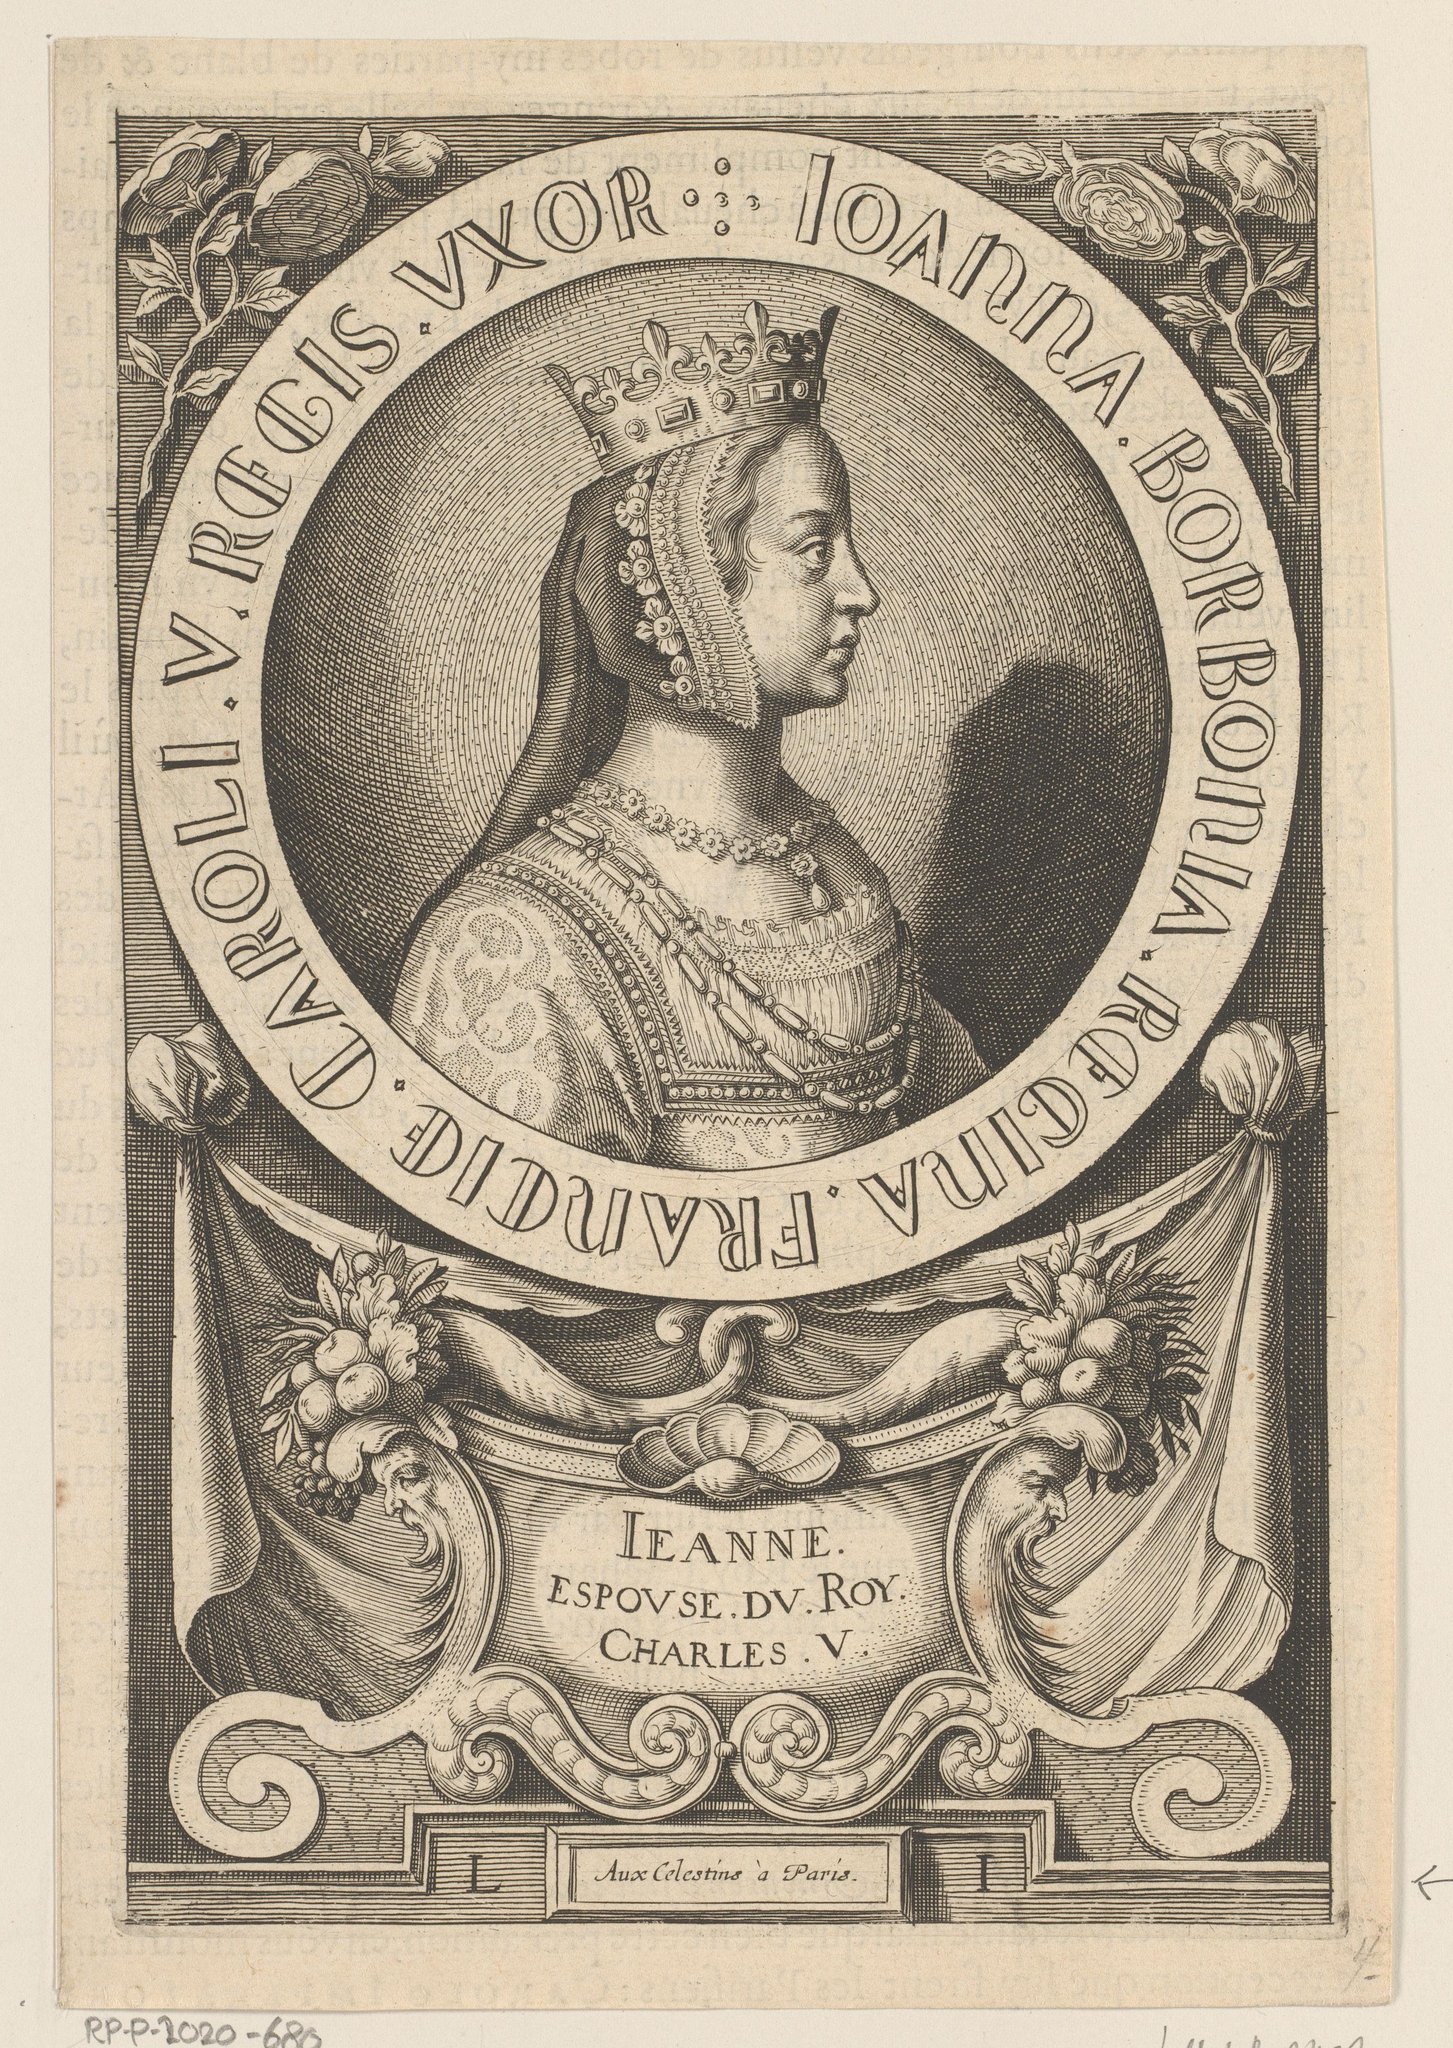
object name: book illustration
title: Portret van Johanna van Bourbon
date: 1643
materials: paper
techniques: engraving, letterpress printing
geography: paris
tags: paris, historical persons, queen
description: Prent uit: Eudes de Mézeray, François. Histoire de France, depuis Faramond jusqu’au regne de Louis le Juste (...). 3 dln. Parijs: Mathieu Guillemot, 1643, dl. 1. Prent waarschijnlijk voor het eerst verschenen in: Bie, Jacques de. Les vrais portraits des rois de France (...). Parijs: Jacques de Bie en Pierre Rocolet, 1634. Prent ook gebruikt in latere publicaties.